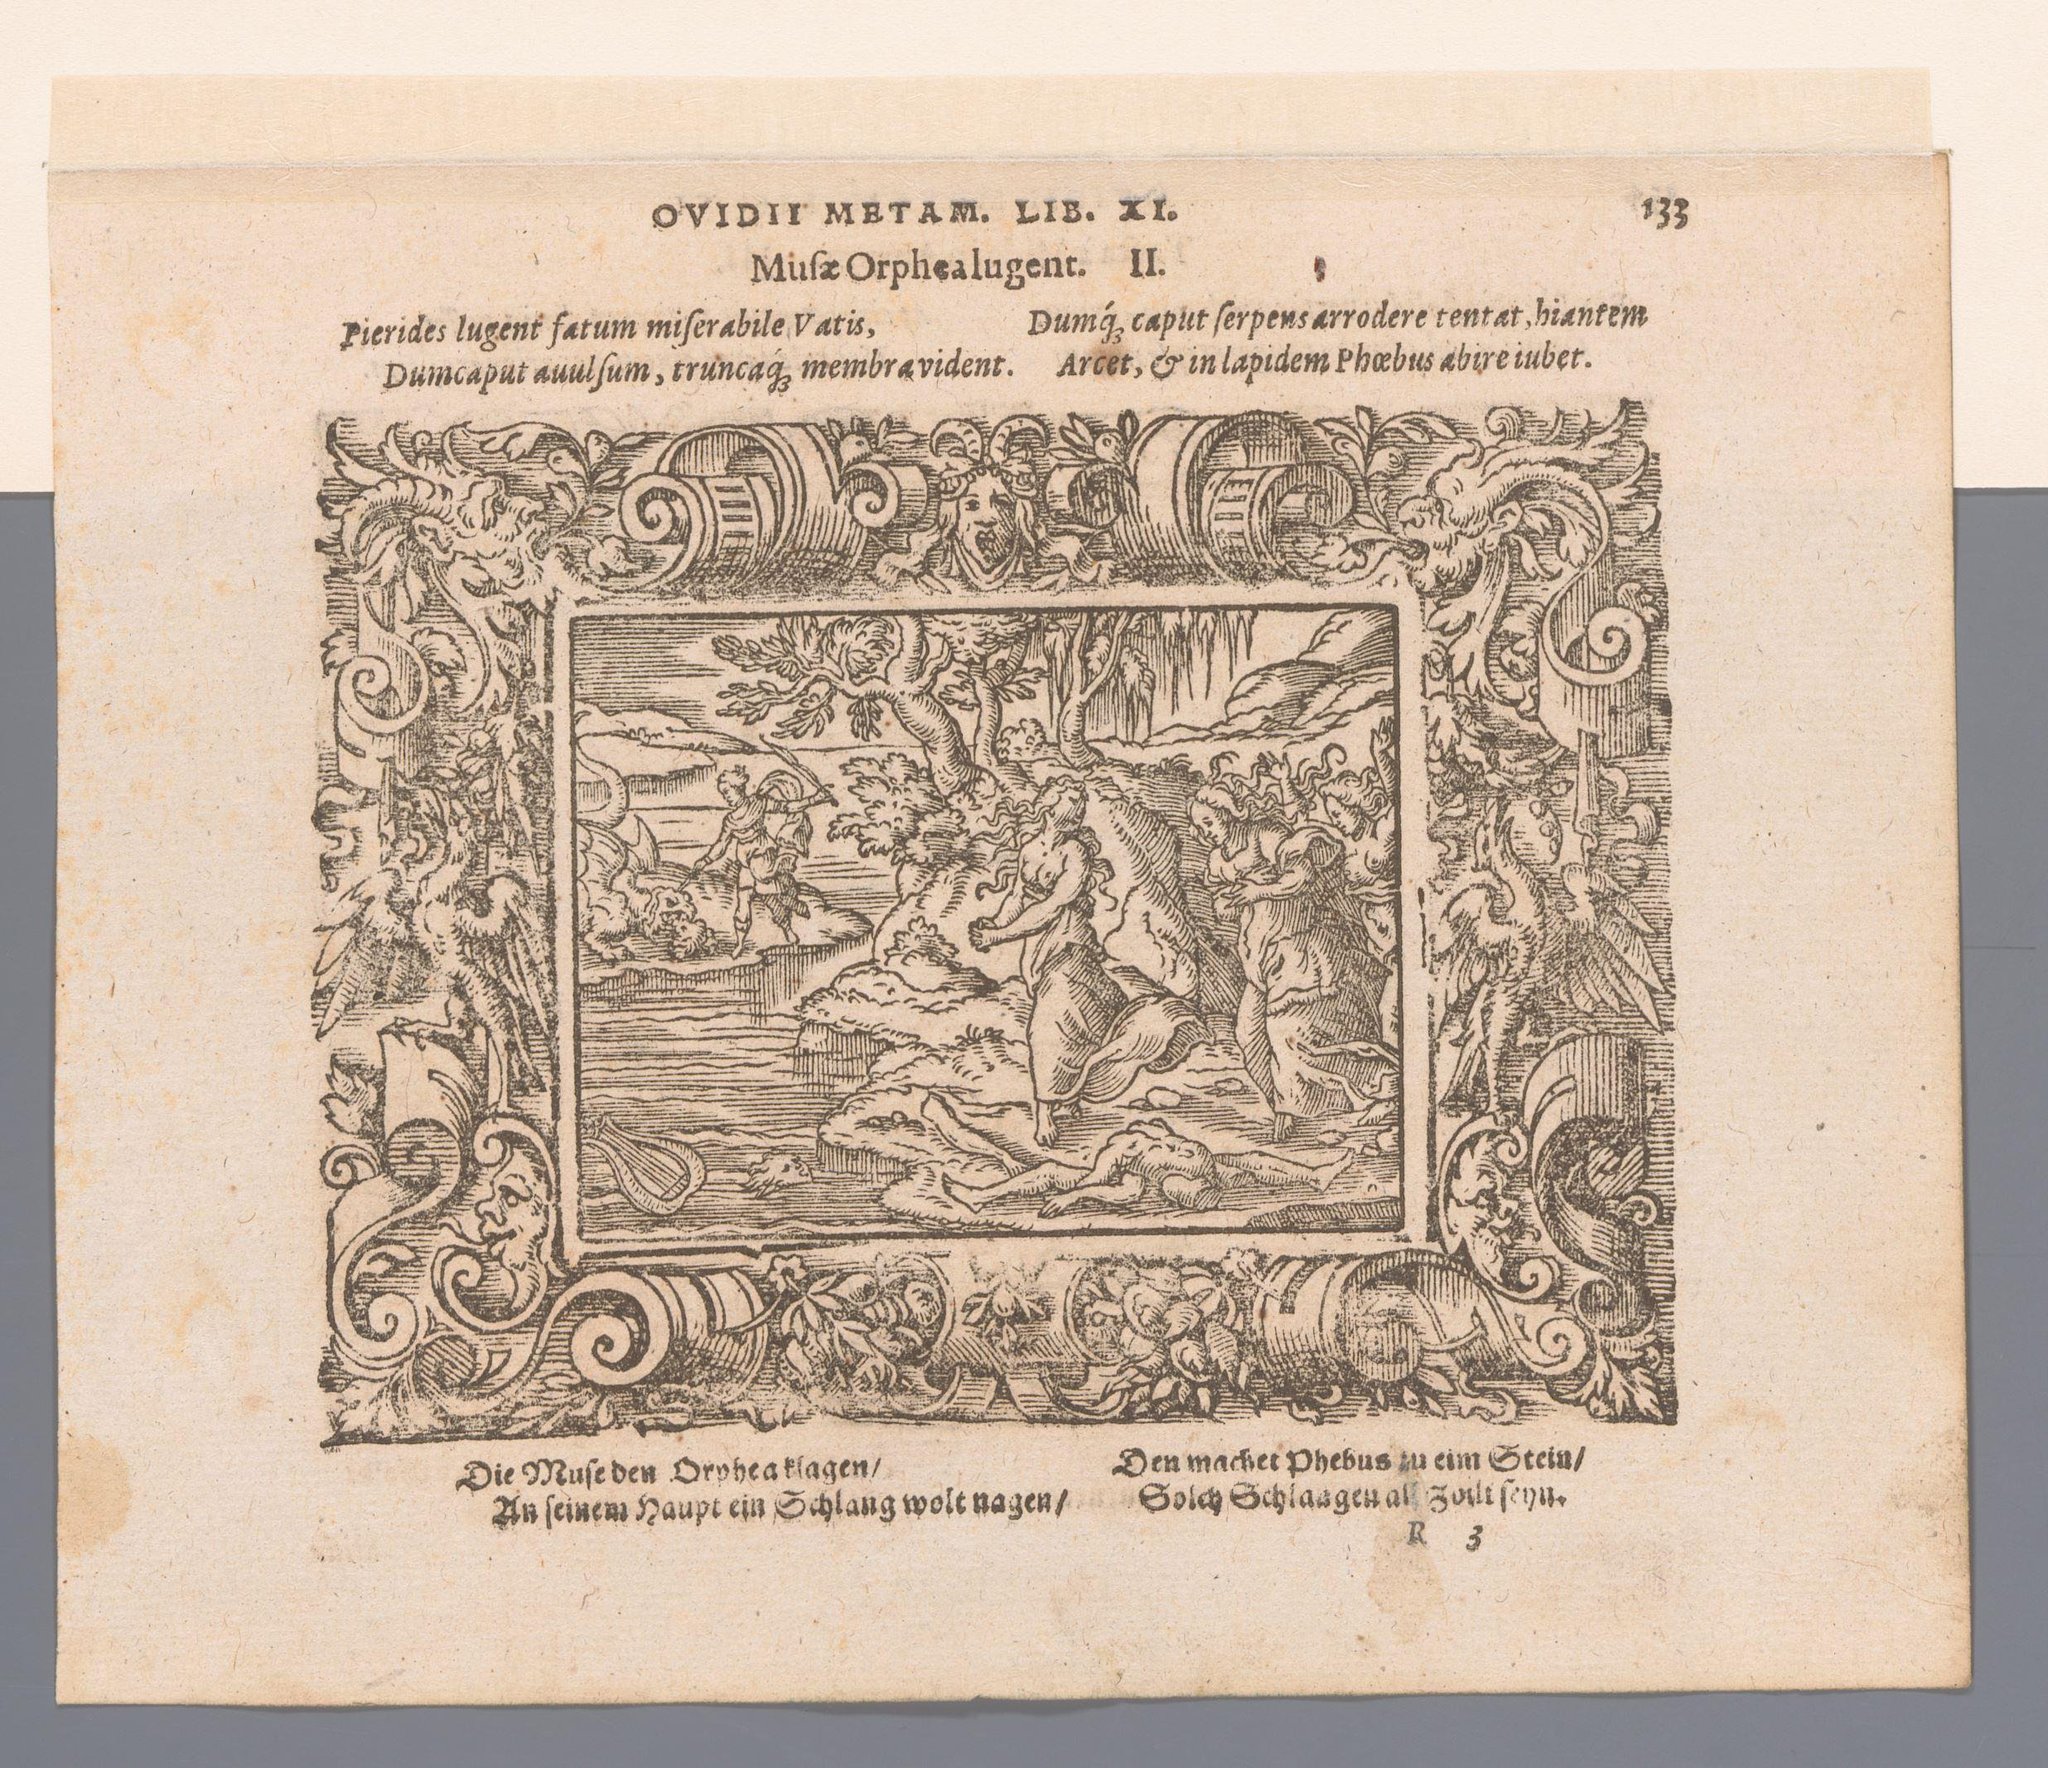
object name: print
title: Hoofd en lier van Orpheus drijvend in de rivier Hebrus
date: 1569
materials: paper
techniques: letterpress printing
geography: frankfurt am main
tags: scrollwork, strapwork ~ ornament, orpheus' head, washed ashore, is attacked by a serpent, attributes of orpheus (with name)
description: Illustratie bij de Metamorfosen van Ovidius, afkomstig uit de publicatie: Posthius, Johannes. Tetrasticha in Ovidii metam. Frankfurt am Main: Georg Rab en Sigmund Feyerabend en erven Weigand Han, 1569. De voorstellingen en ornamentranden van deze boekillustraties zijn van twee aparte blokken gedrukt. Beide werden afzonderlijk van elkaar ook gebruikt voor andere publicaties, en de ornamentranden werden eveneens binnen deze publicatie meerdere keren gebruikt.